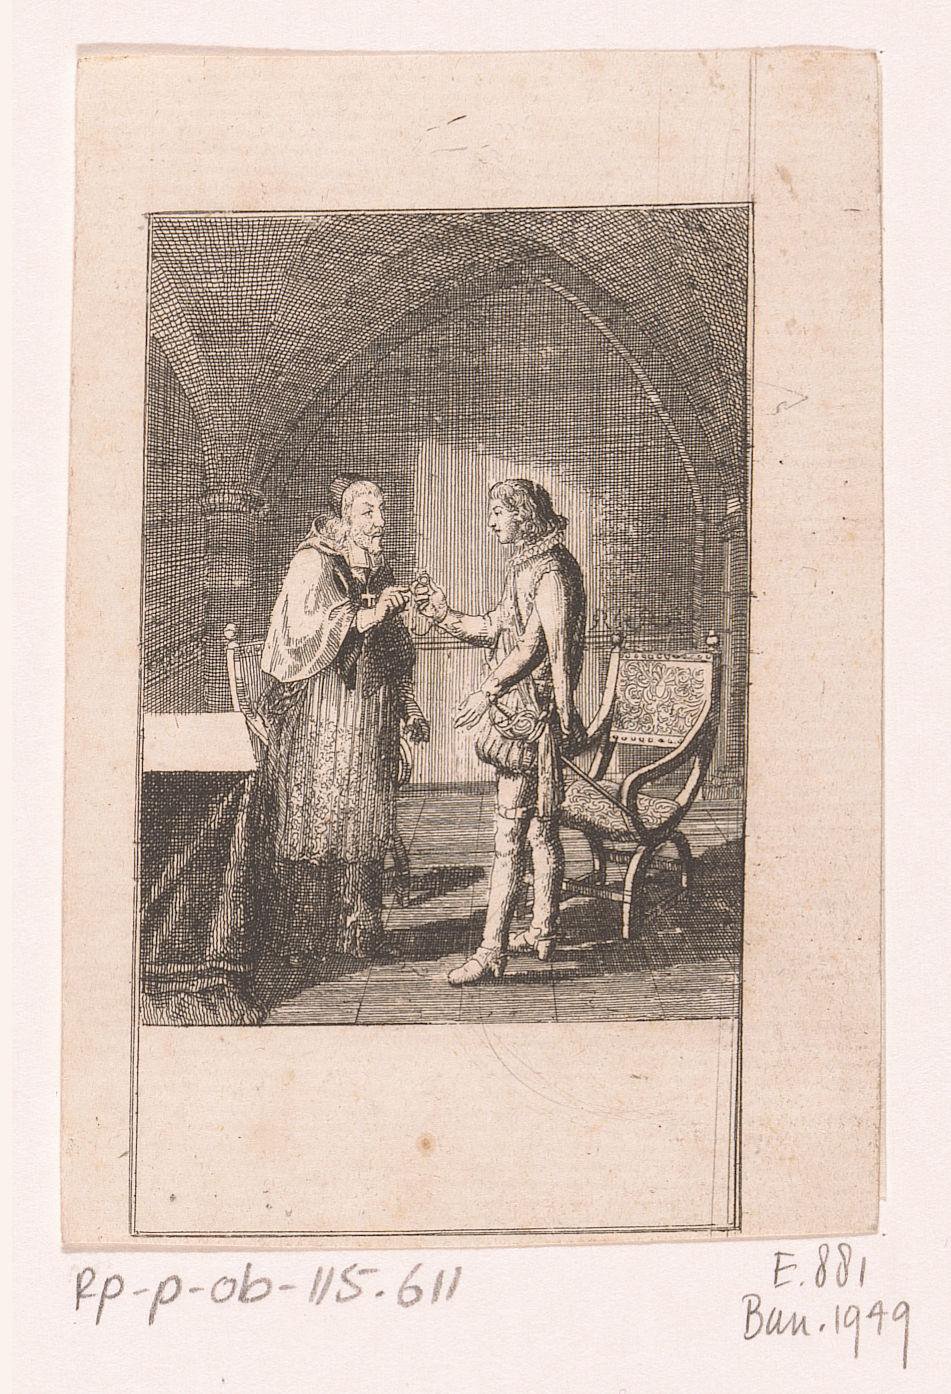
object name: print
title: Michele Bonelli in gesprek met Hendrik IV van Navarra over zijn huwelijk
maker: daniel nikolaus chodowiecki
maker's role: draughtsman, print maker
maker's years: 1726-1801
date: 1798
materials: paper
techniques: etching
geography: berlin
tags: rome, paris, hendrik iv (koning van frankrijk en navarra), ring, conversation, dialogue; conversation piece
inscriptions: collector's mark: Lugt 2228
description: Prent gebruikt voor: Historisch-genealogischer Kalender auf das Jahr 1799 und 1800. Die Geschichte der Bartholomäusnacht oder die Bluthochzeit zu Paris. Berlijn: Johann Friedrich Unger, [1798].